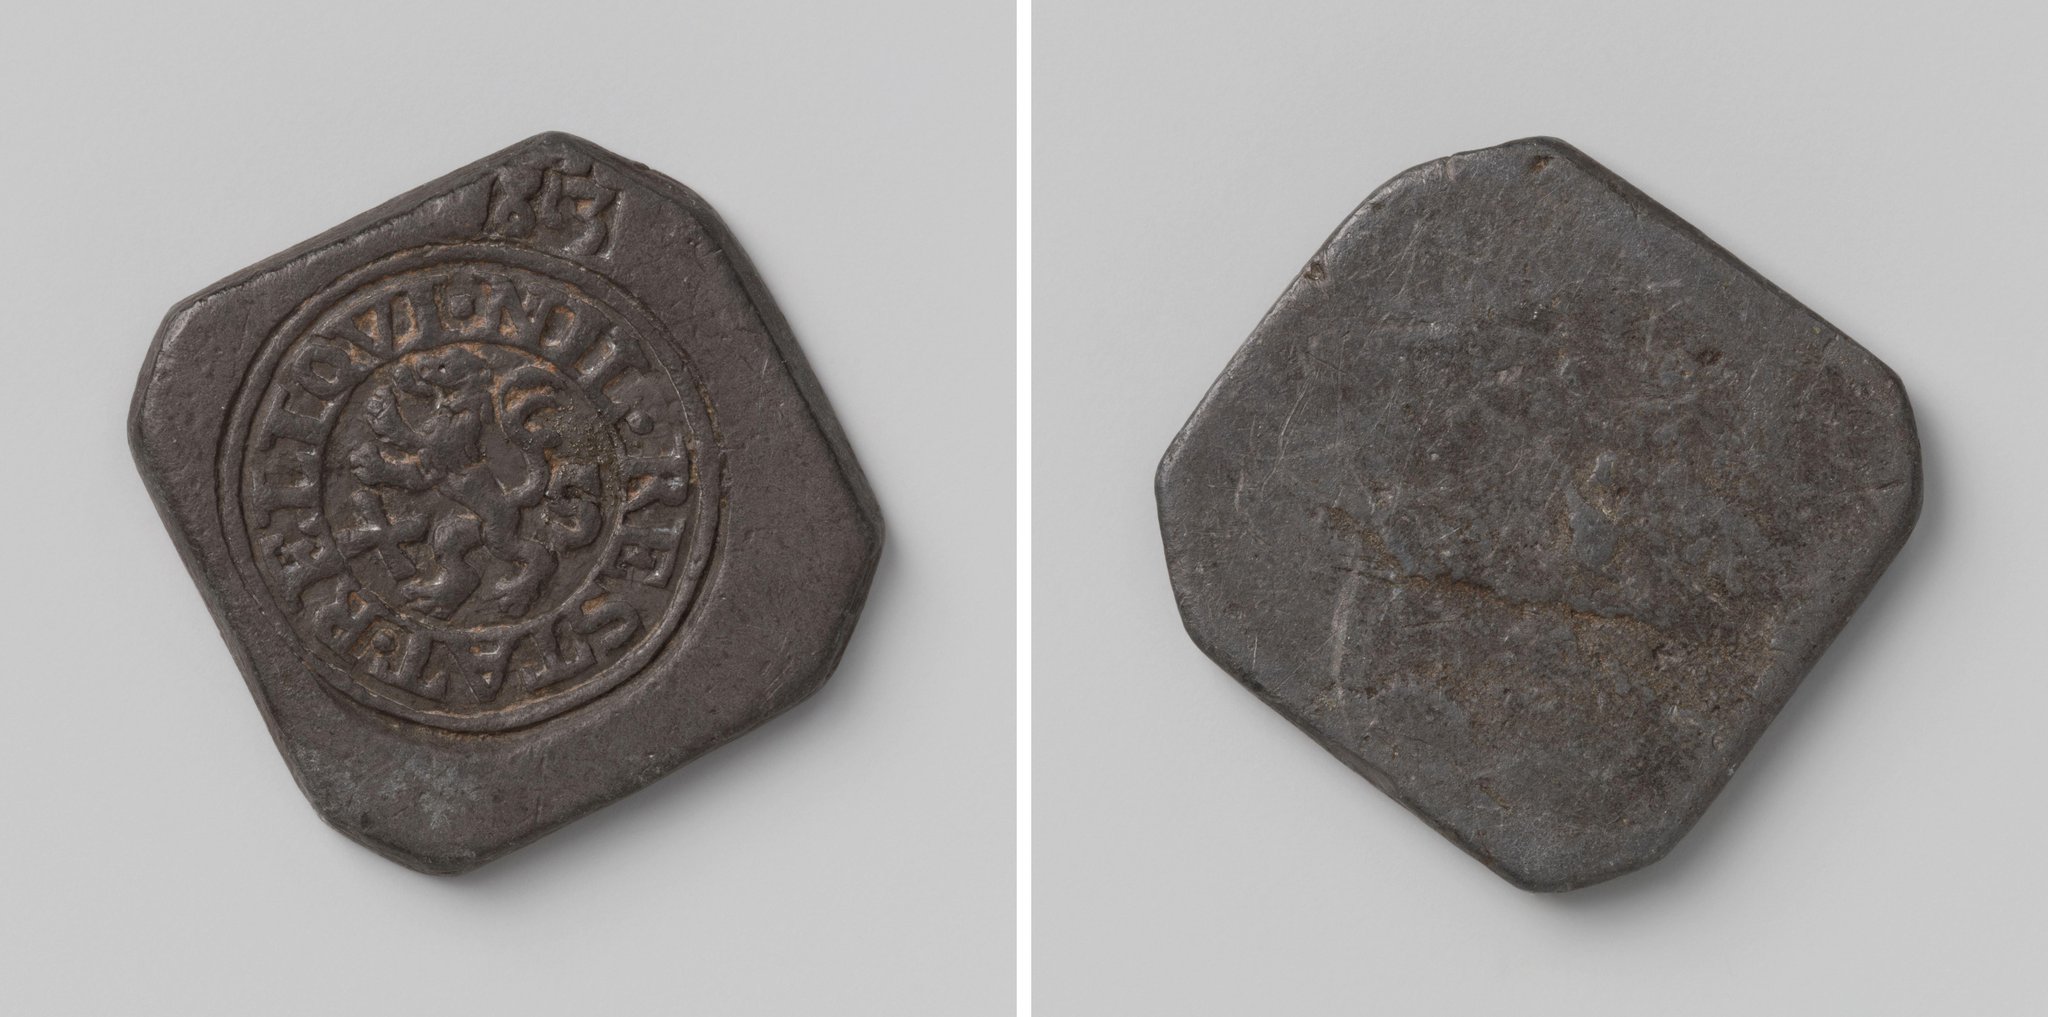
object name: coin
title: Tien stuiver, noodmunt uit Ieper, geslagen tijdens het beleg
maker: Anonymous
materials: tin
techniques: striking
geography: ieper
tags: ieper (stad), inname van ieper (1584), tachtigjarige oorlog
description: eenzijdige, vierkante noodmunt van Ieper, met afgeschuinde hoeken. Voorzijde: twee stempels boven elkaar: bovenste stempel: cijfer 83; onderste stempel: wapenschild tussen letters X en S binnen omschrift. Keerzijde: blanco